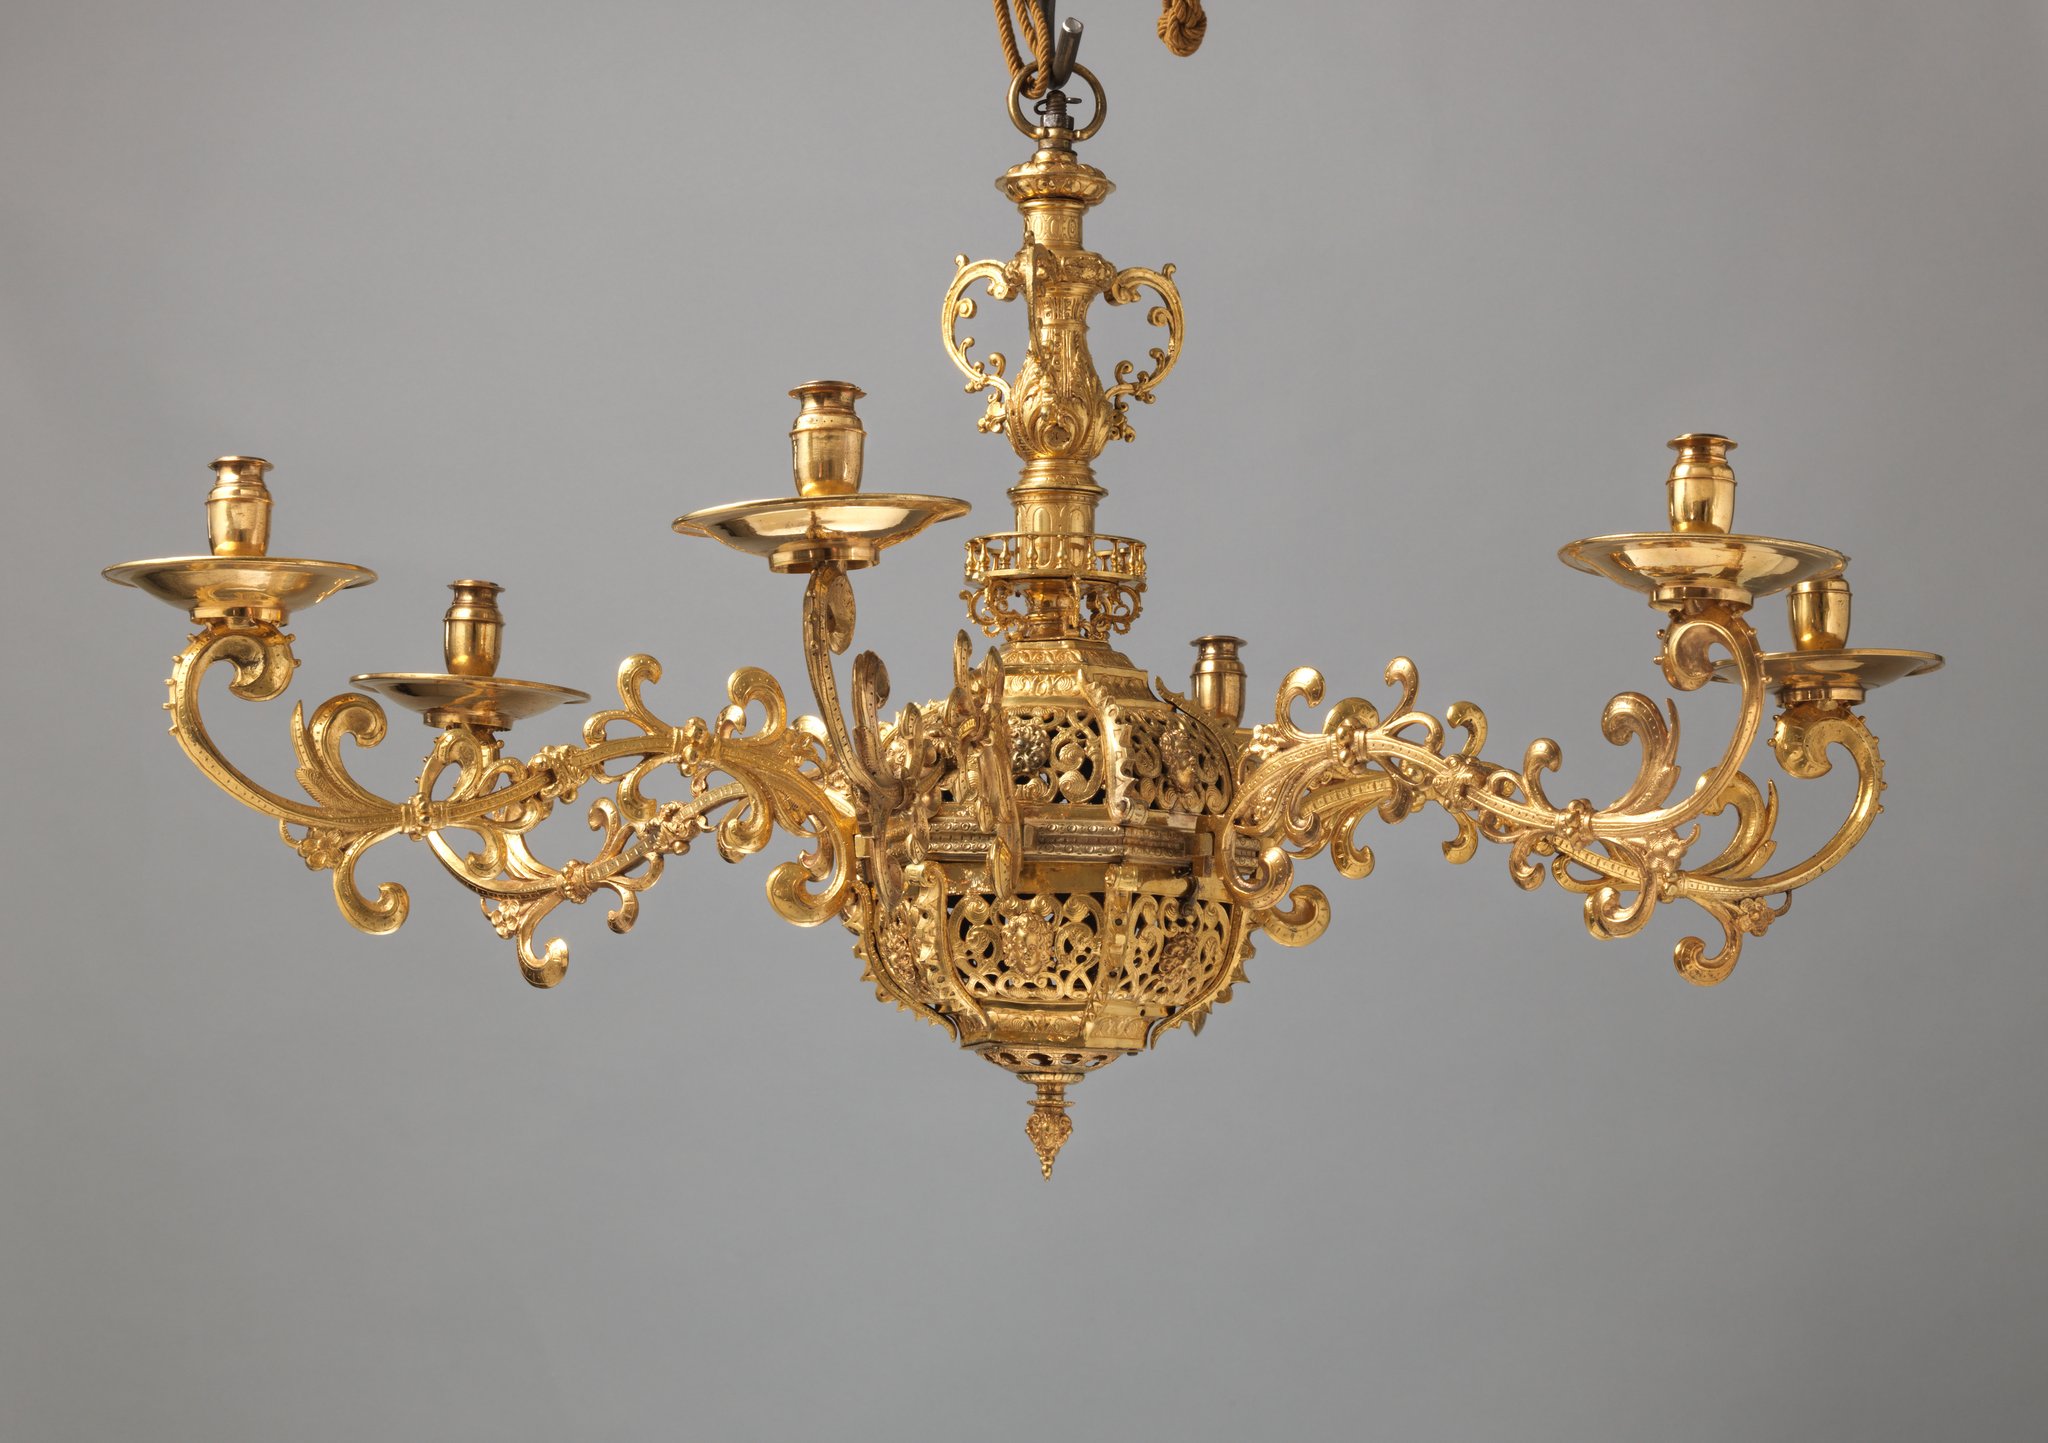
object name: six branch chandelier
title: Six-branch chandelier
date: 1580-1600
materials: bronze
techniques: gilding